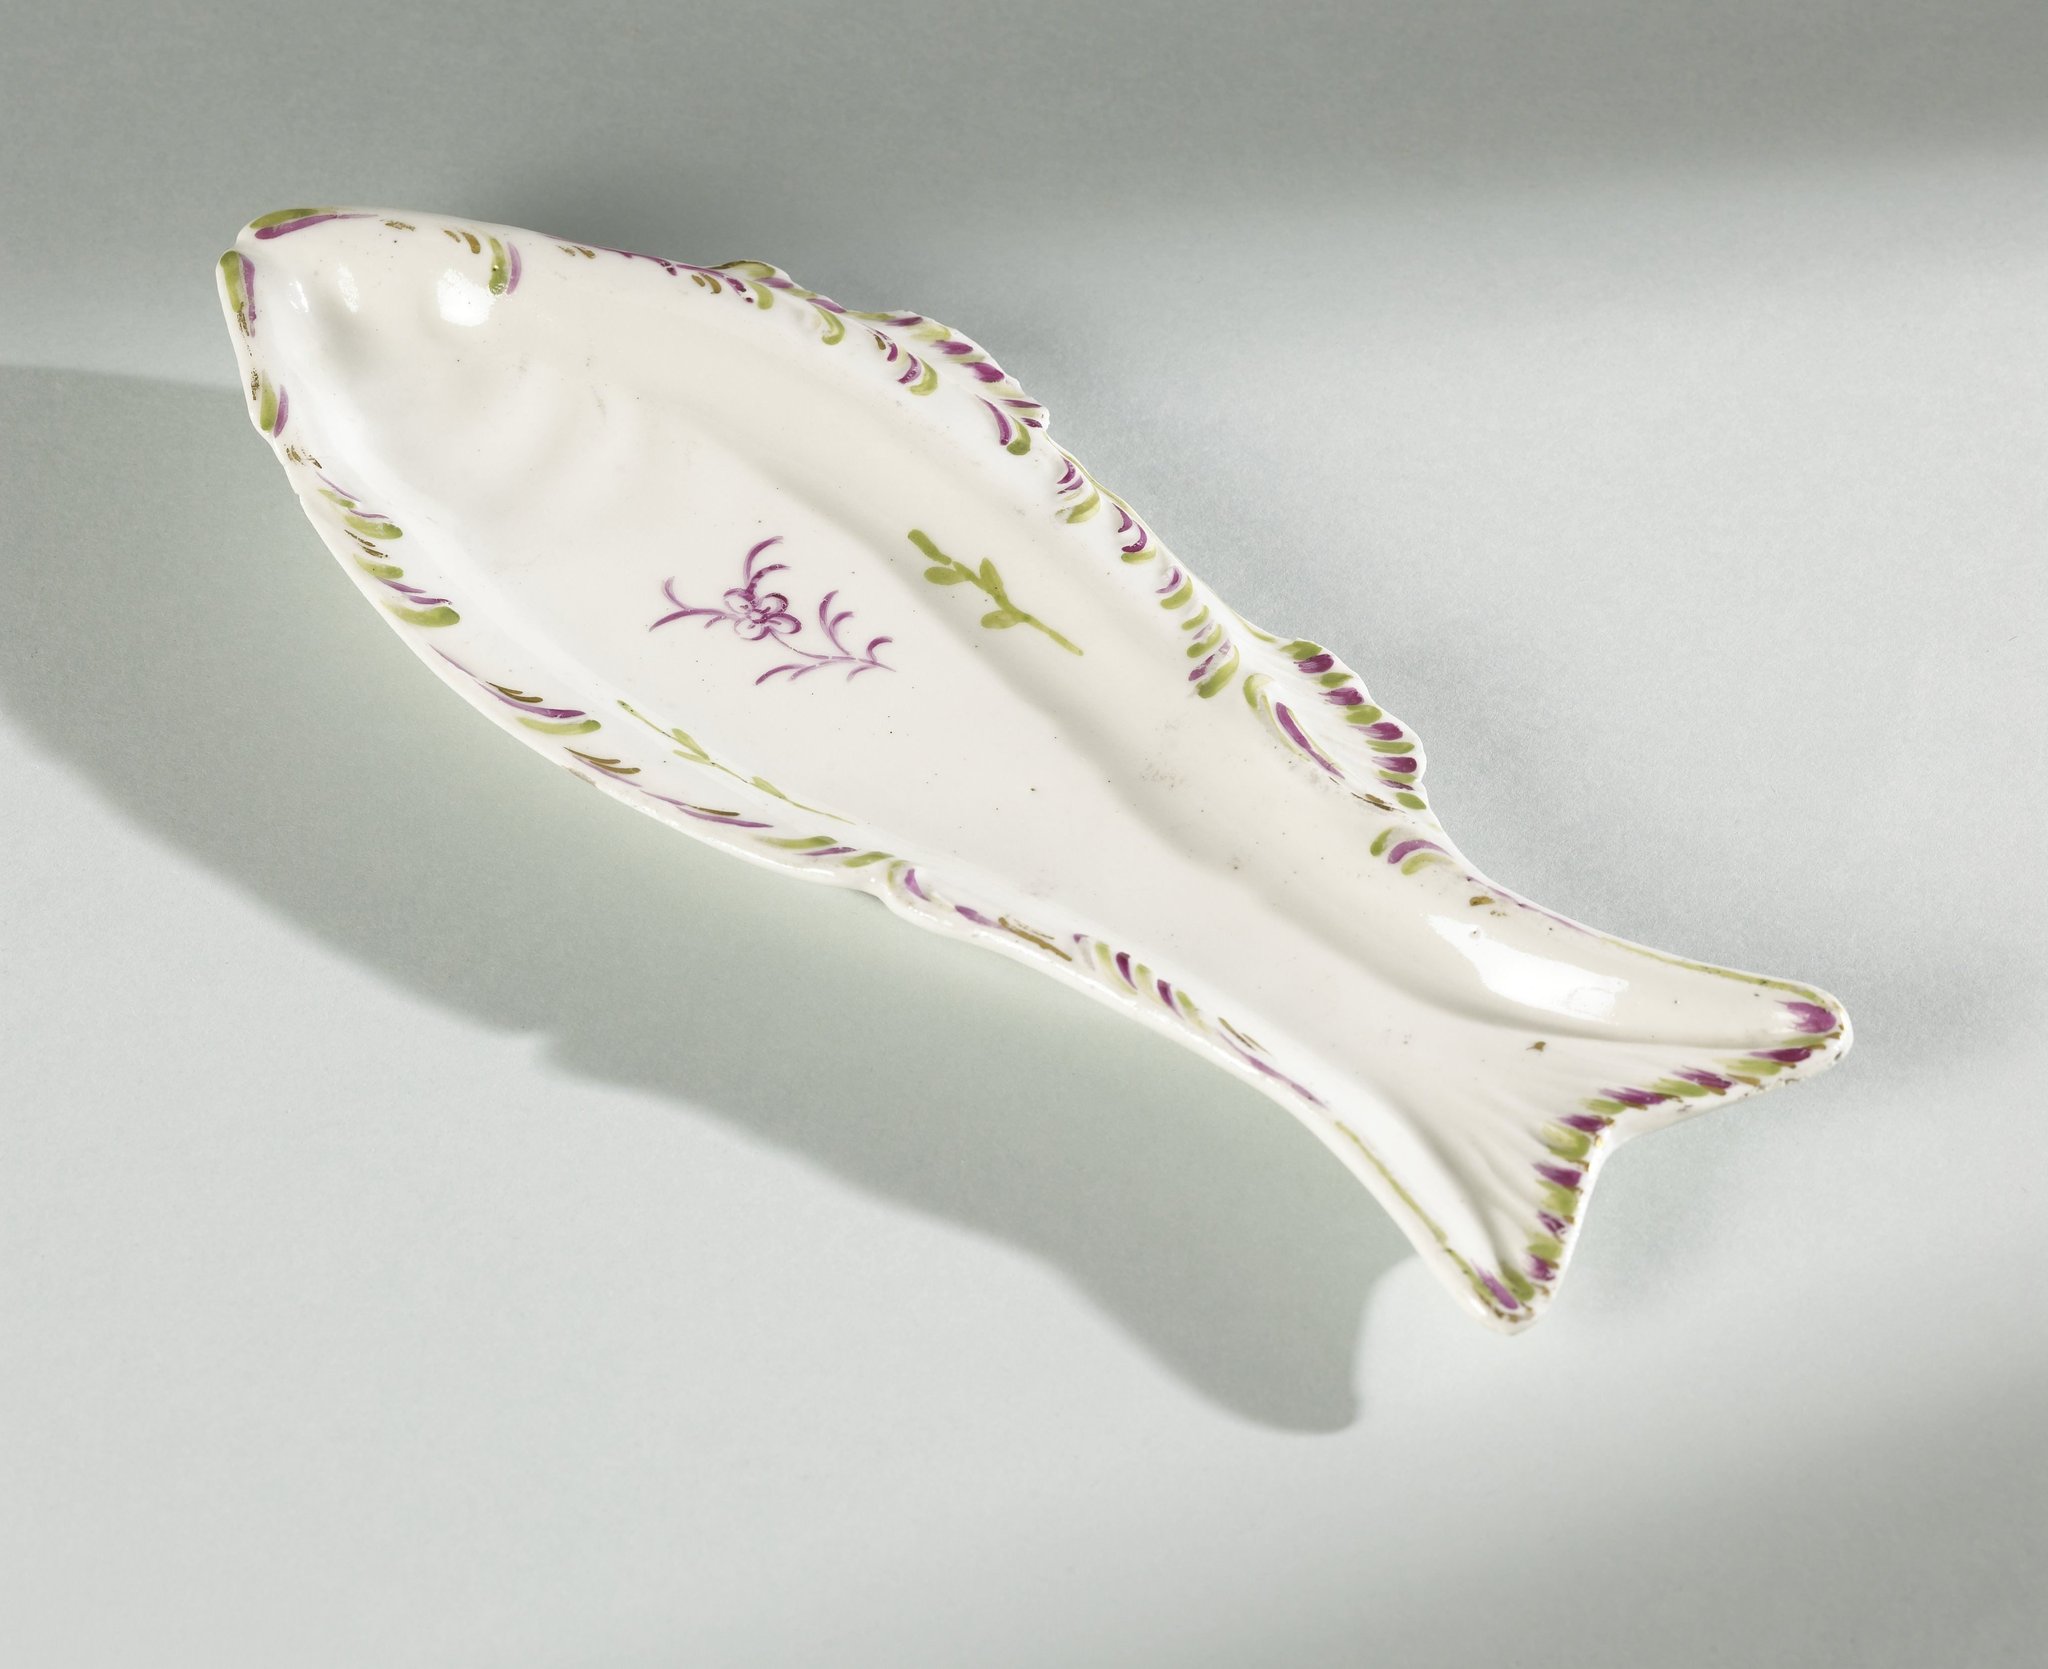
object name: haringschaal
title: Haringschaal, beschilderd met takjes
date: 1774-1778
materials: porcelain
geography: loosdrecht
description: Two herring dishes. Porcelain. Loosdrecht, c. 1774 - 1778. Factory of Johannes de Mol.